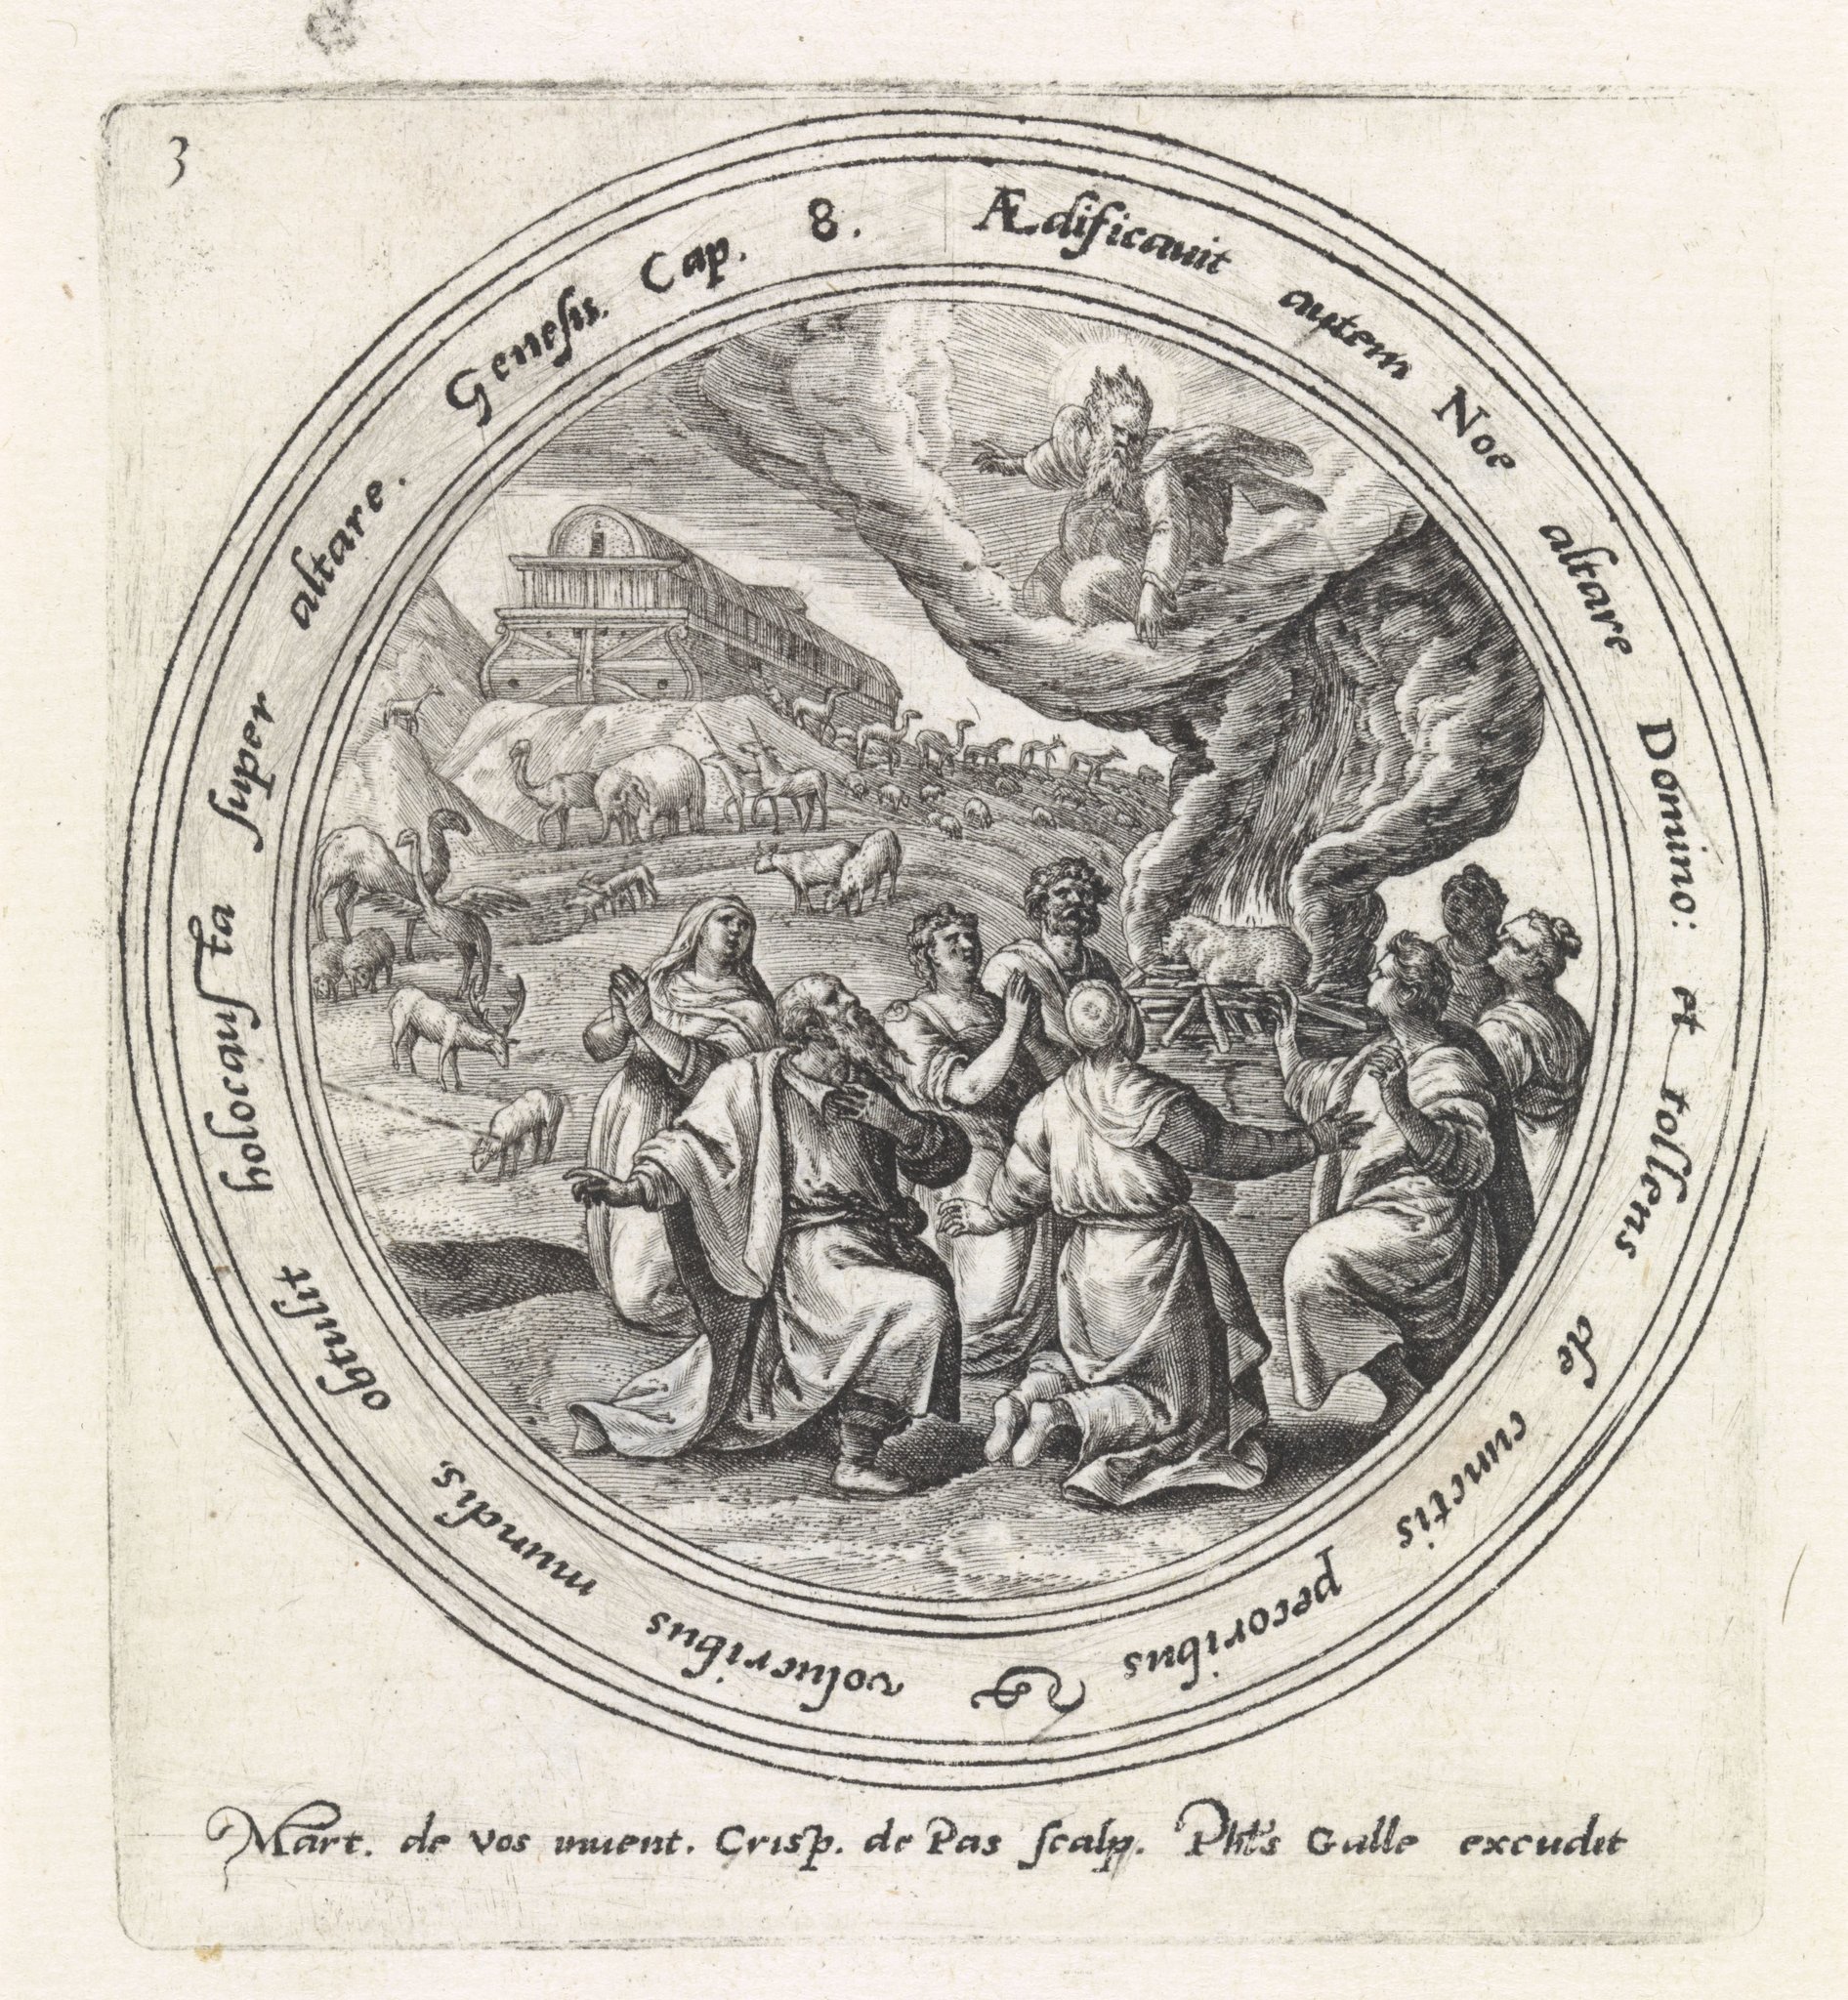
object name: print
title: Het offer van Noach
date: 1580-1588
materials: paper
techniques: engraving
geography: antwerp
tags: noah's sacrifice; various animals are offered, possibly a lamb, a dove and a ram (often combined with the rainbow of the covenant)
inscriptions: collector's mark: Lugt 2760, collector's mark: Lugt 2228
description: Noach en zijn familie zitten geknield voor een offeraltaar met daarop een lam. In de lucht God de Vader. Op de achtergrond staat op een heuvel de ark. Een stoet van dieren verlaat de ark. De voorstelling is gevat in een cirkelvormige omlijsting met een randschrift in het Latijn.